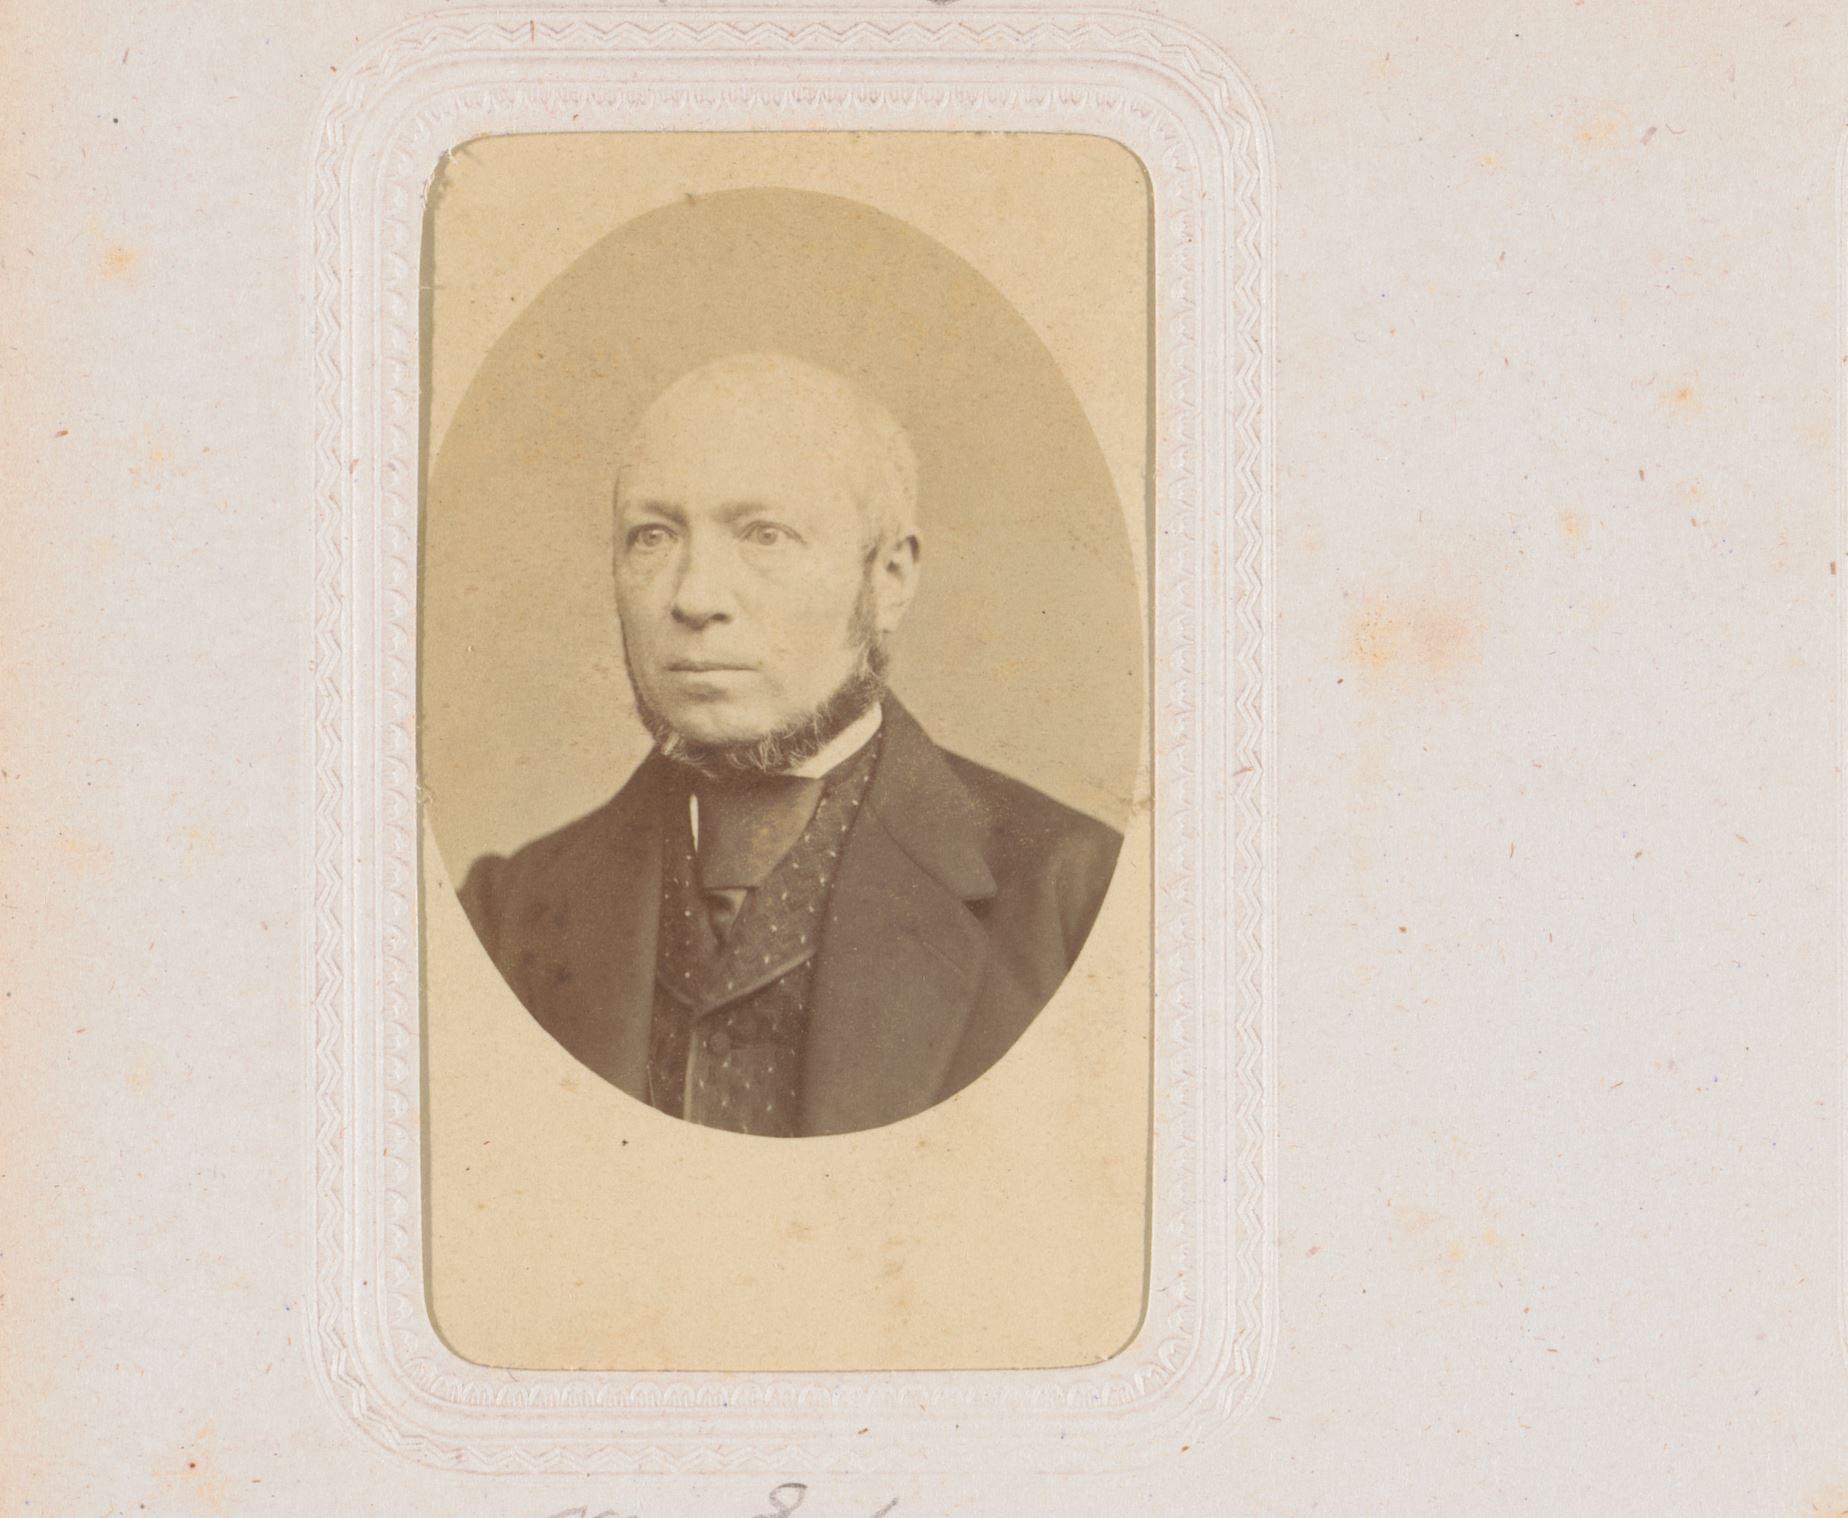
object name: carte de visite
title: Portret van een man, aangeduid als A.van Eck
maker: kornelis willem schorteldoek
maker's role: boekbinder, fotograaf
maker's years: 1800-1885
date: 1855-1885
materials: cardboard, photographic support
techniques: albumen print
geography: gorinchem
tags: historical persons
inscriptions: inscription: ‘ANNDENKEN/ 2 DEC : 1871./ Schorteldoek - POTH: GORICHEM’, name: ‘A. van Eck’, name: ‘Van Eck’